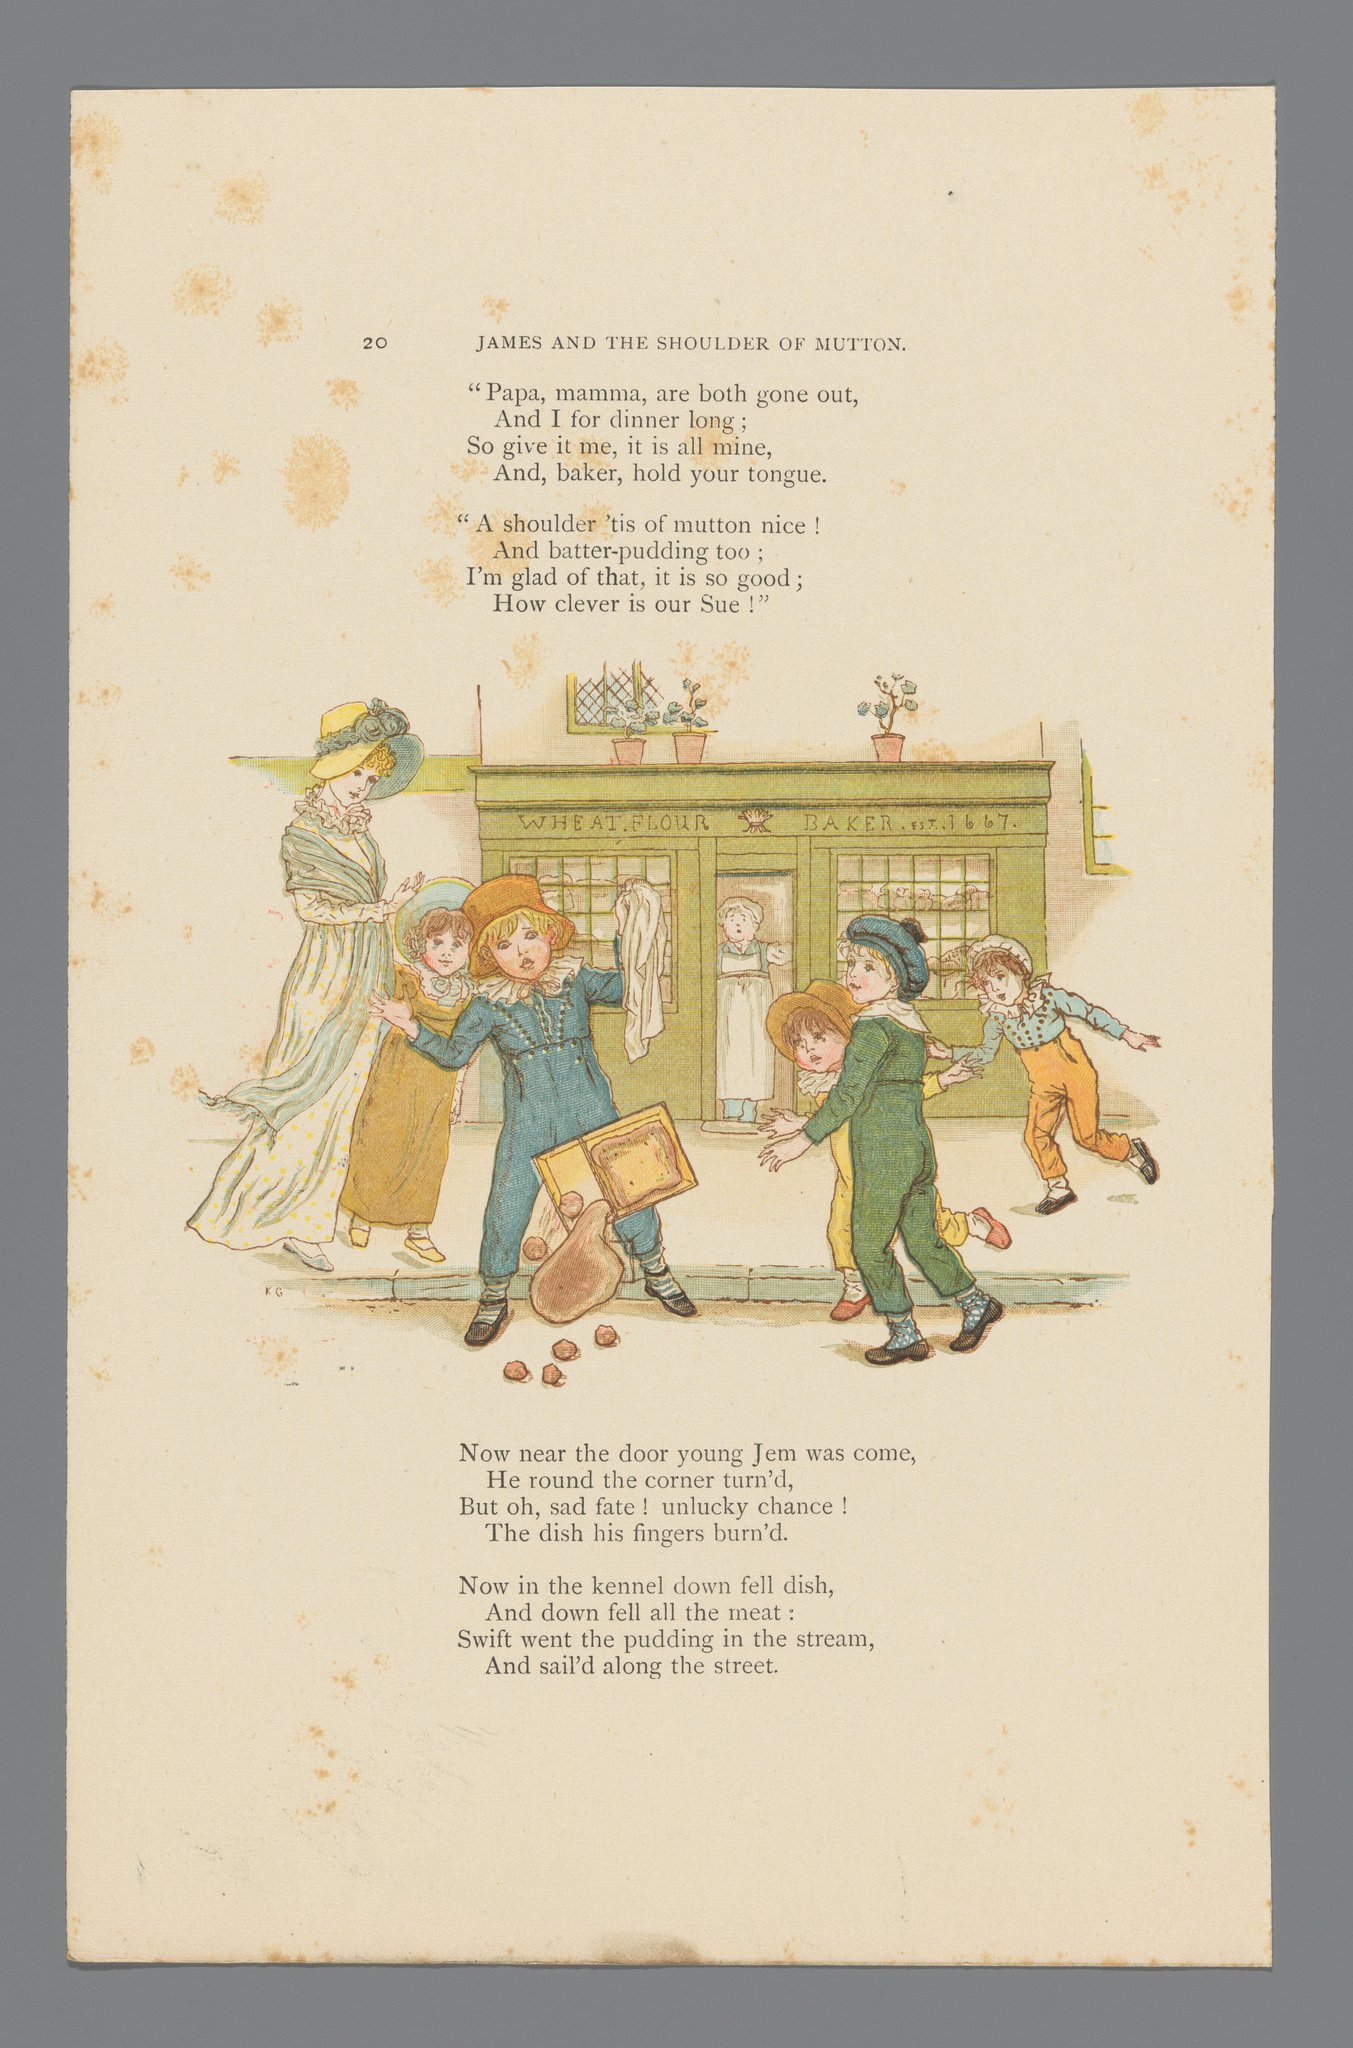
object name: print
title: Kind voor een bakkerij laat brood vallen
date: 1883-1927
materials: paper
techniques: wood engraving, letterpress printing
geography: london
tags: releasing something, child, baker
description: Prent uit: Jane en Ann Taylor. Little Ann and other poems. Londen: George Routledge & Sons, [1883], p. 20. Of een latere uitgave.